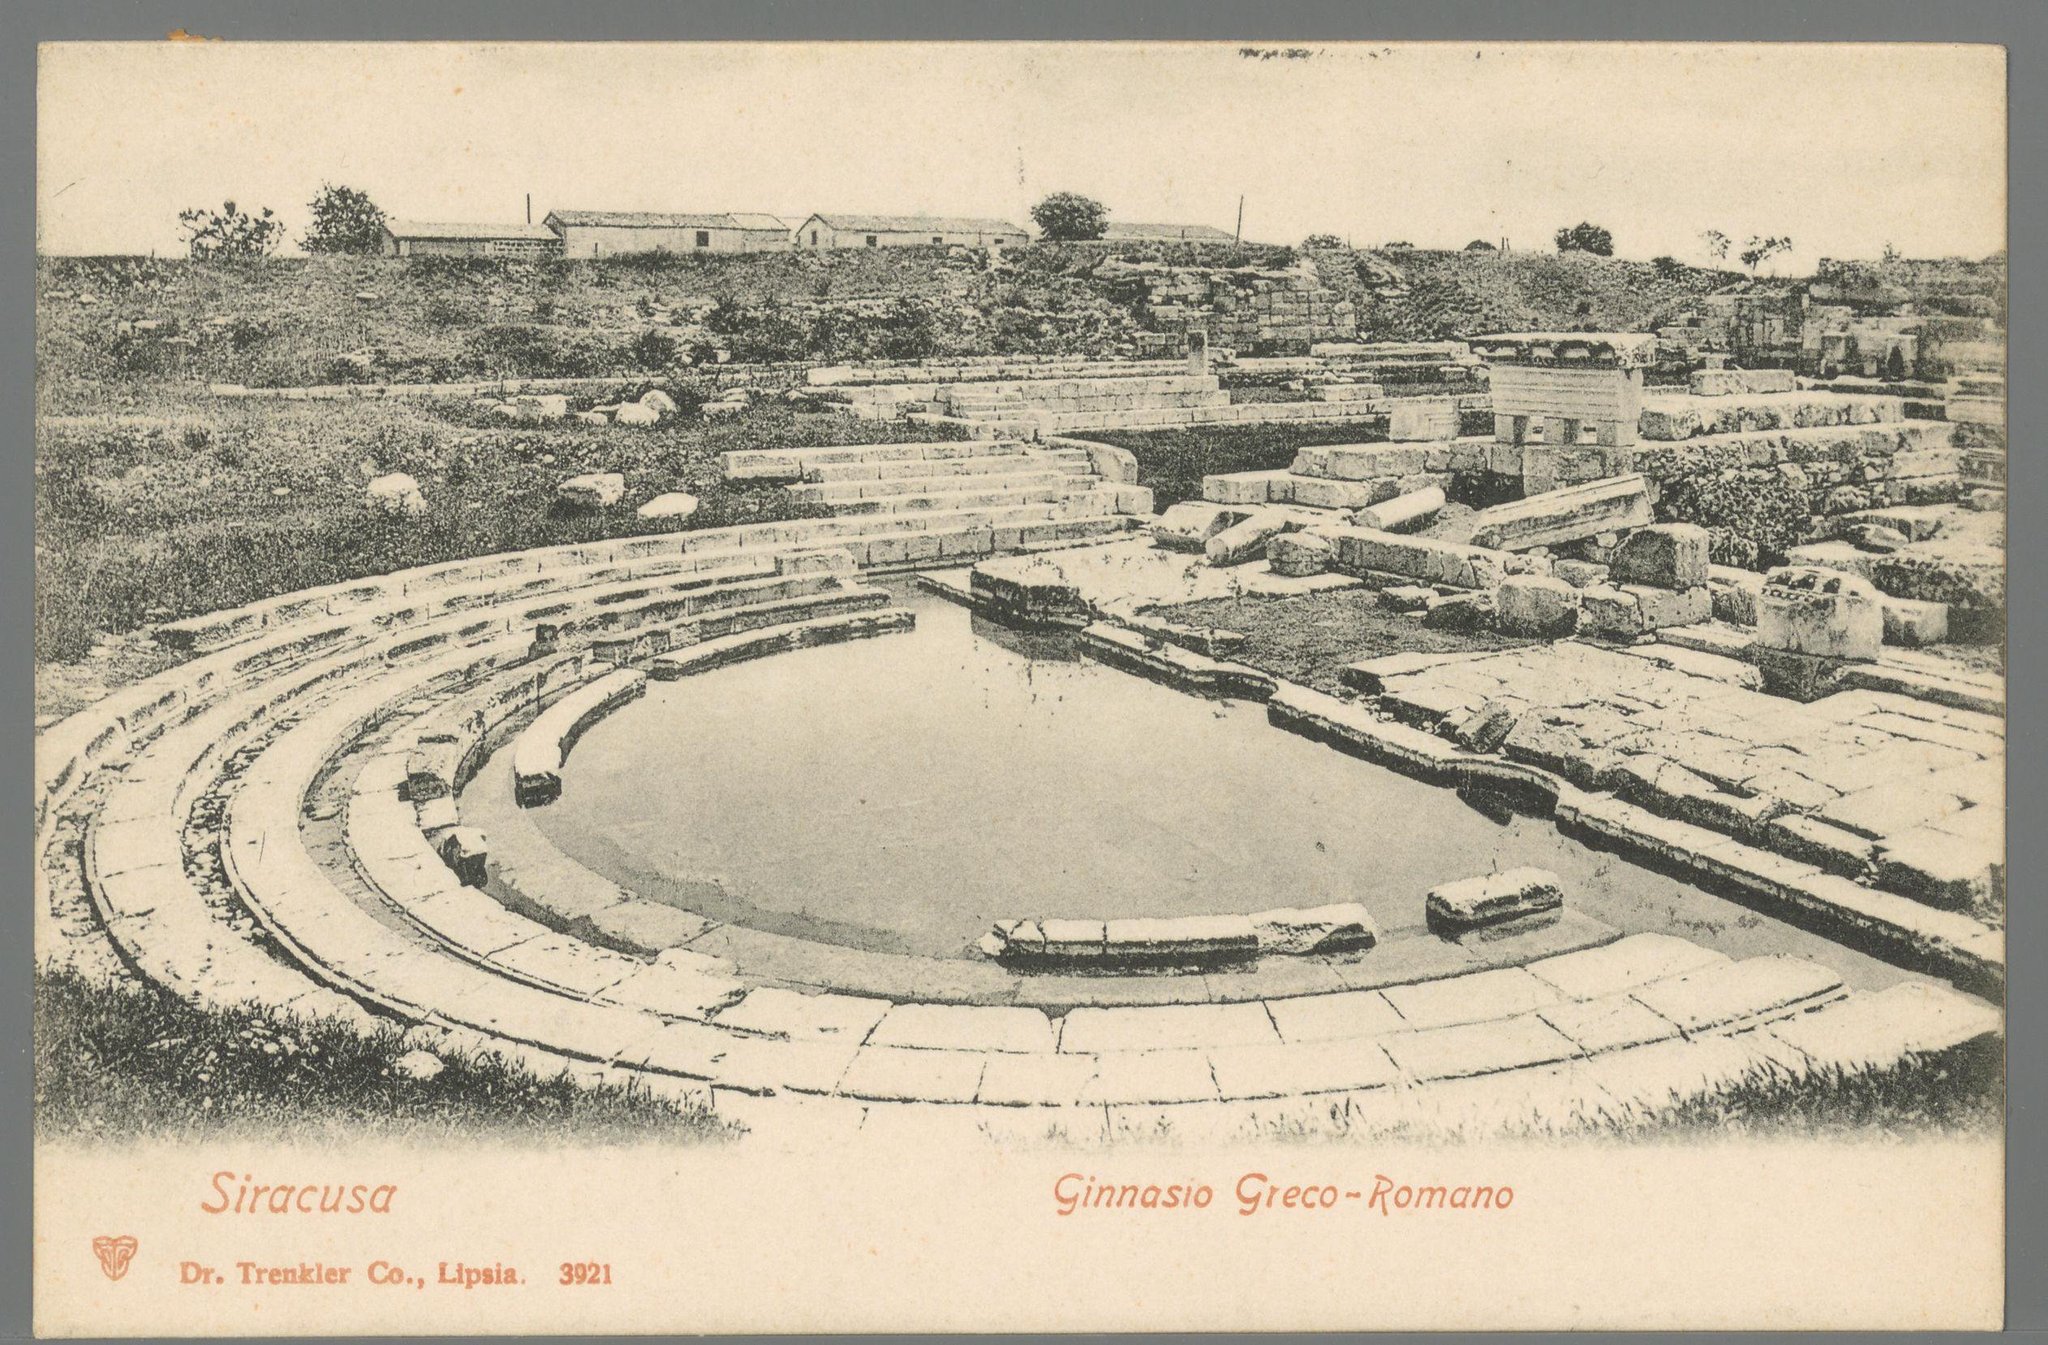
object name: photomechanical print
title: Siracusa. Ginnasio Greco-Romano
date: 1885-1903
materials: cardboard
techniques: photograph, writing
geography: leipzig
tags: ruin of a building ~ architecture, athletics, gymnastics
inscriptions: postage stamp